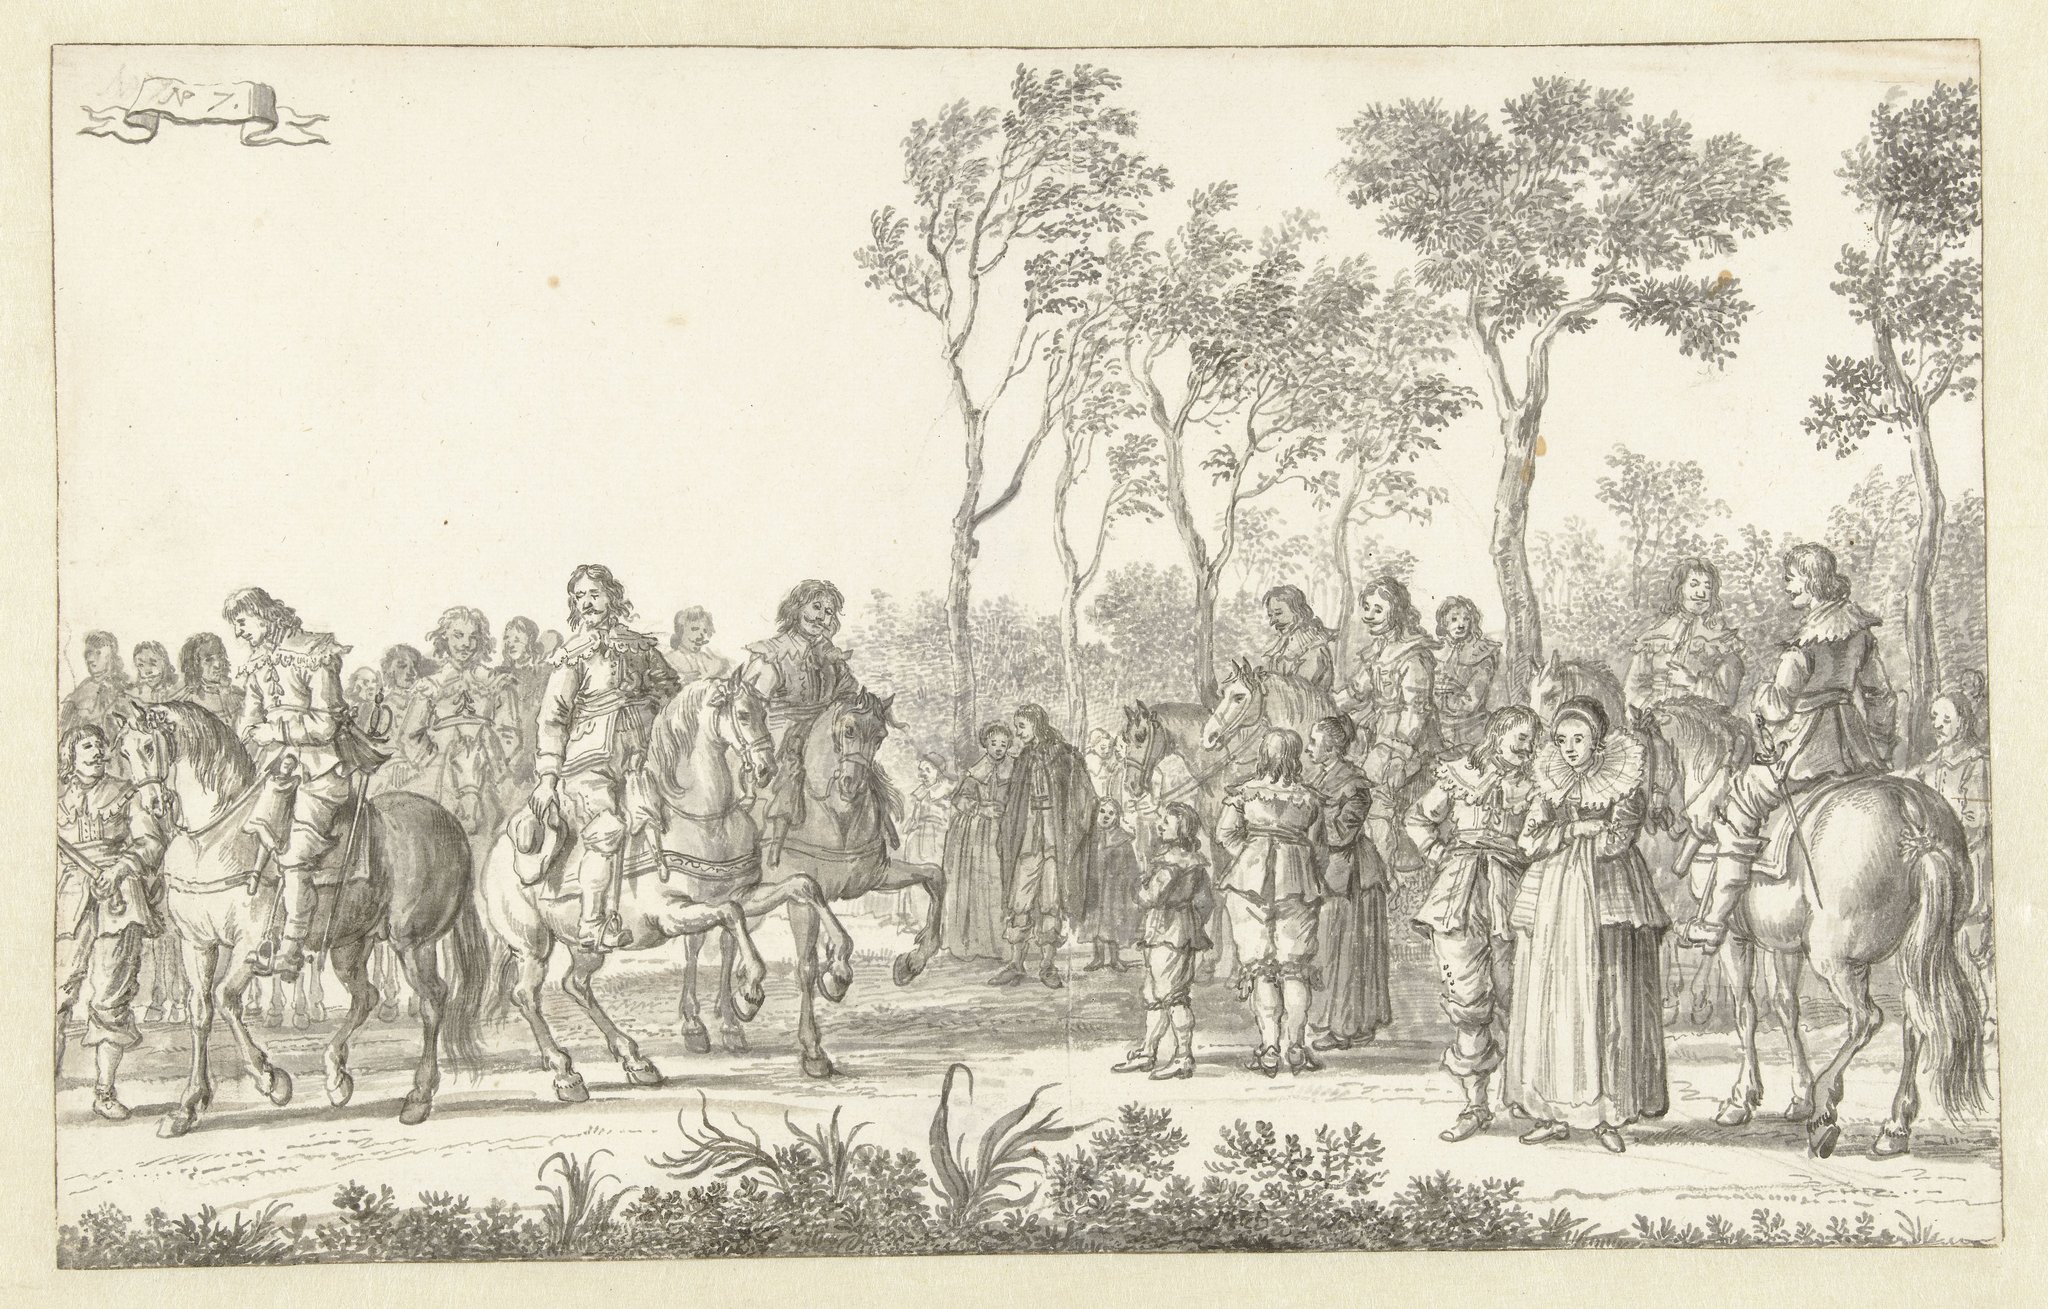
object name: design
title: Ontwerptekeningen voor de prentreeks van de intocht van Maria de' Medici te Amsterdam in 1638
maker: jan martszen de jonge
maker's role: draughtsman, painter, print maker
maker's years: 1609-1647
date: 1638-1639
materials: chalk, ink, paper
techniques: brush, pen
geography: northern netherlands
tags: cologne, maria de' medici, land forces (+ cavalry, horsemen), triumphal entry and public reception, pageant, 'entrée solennelle', 'joyeuse entrée', military celebrations, amsterdam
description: De stoet waarin Maria de Medici haar intocht in Amsterdam deed, op 31 Augustus 1638: Ruiters, in de bocht gezien; rechts toeschouwers te voet en te paard.